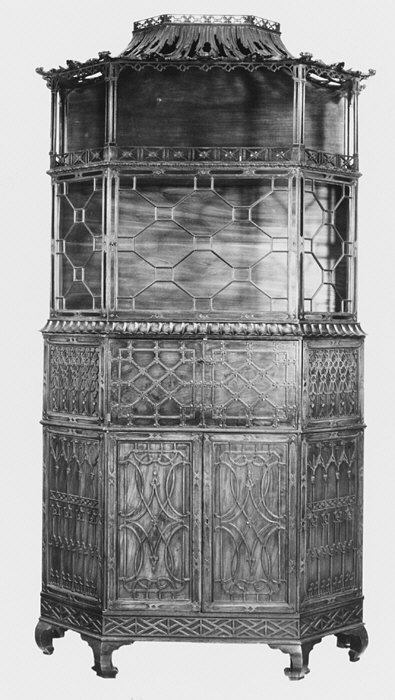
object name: secretary cabinet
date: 1760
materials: wood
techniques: veneering